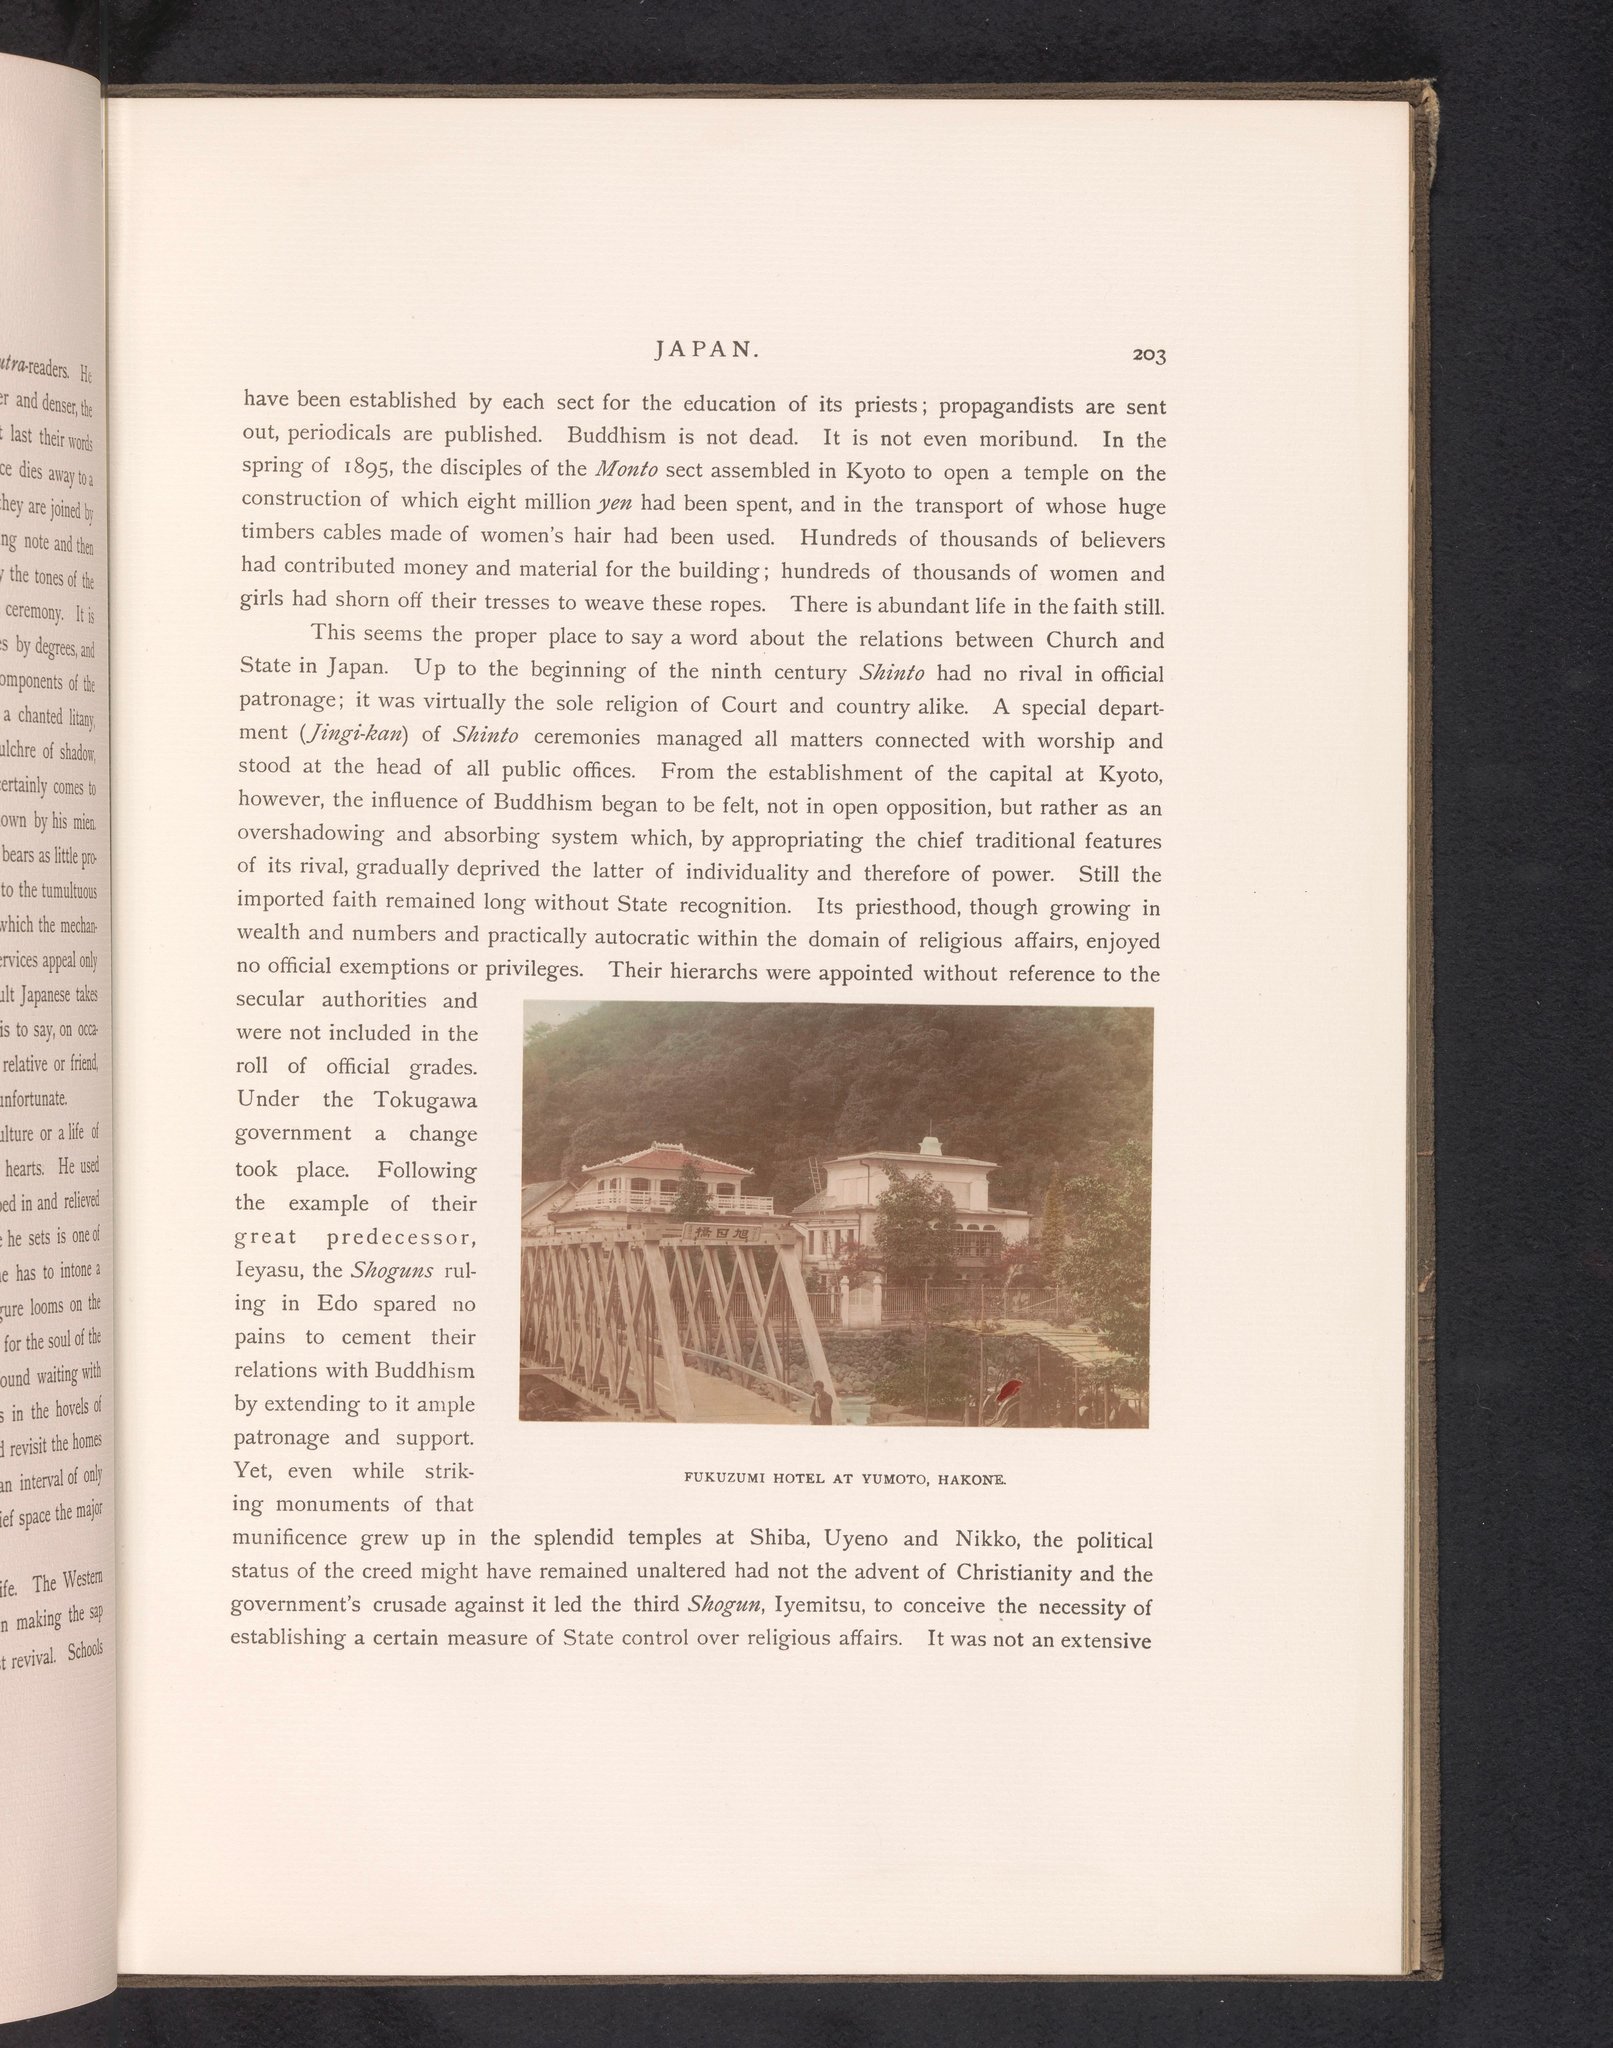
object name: photograph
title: Fukuzumi Hotel at Yumoto, Hakone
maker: Anonymous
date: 1887-1897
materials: photographic support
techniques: albumen print, hand coloring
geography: japan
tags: bridge, hotel, hostelry, inn